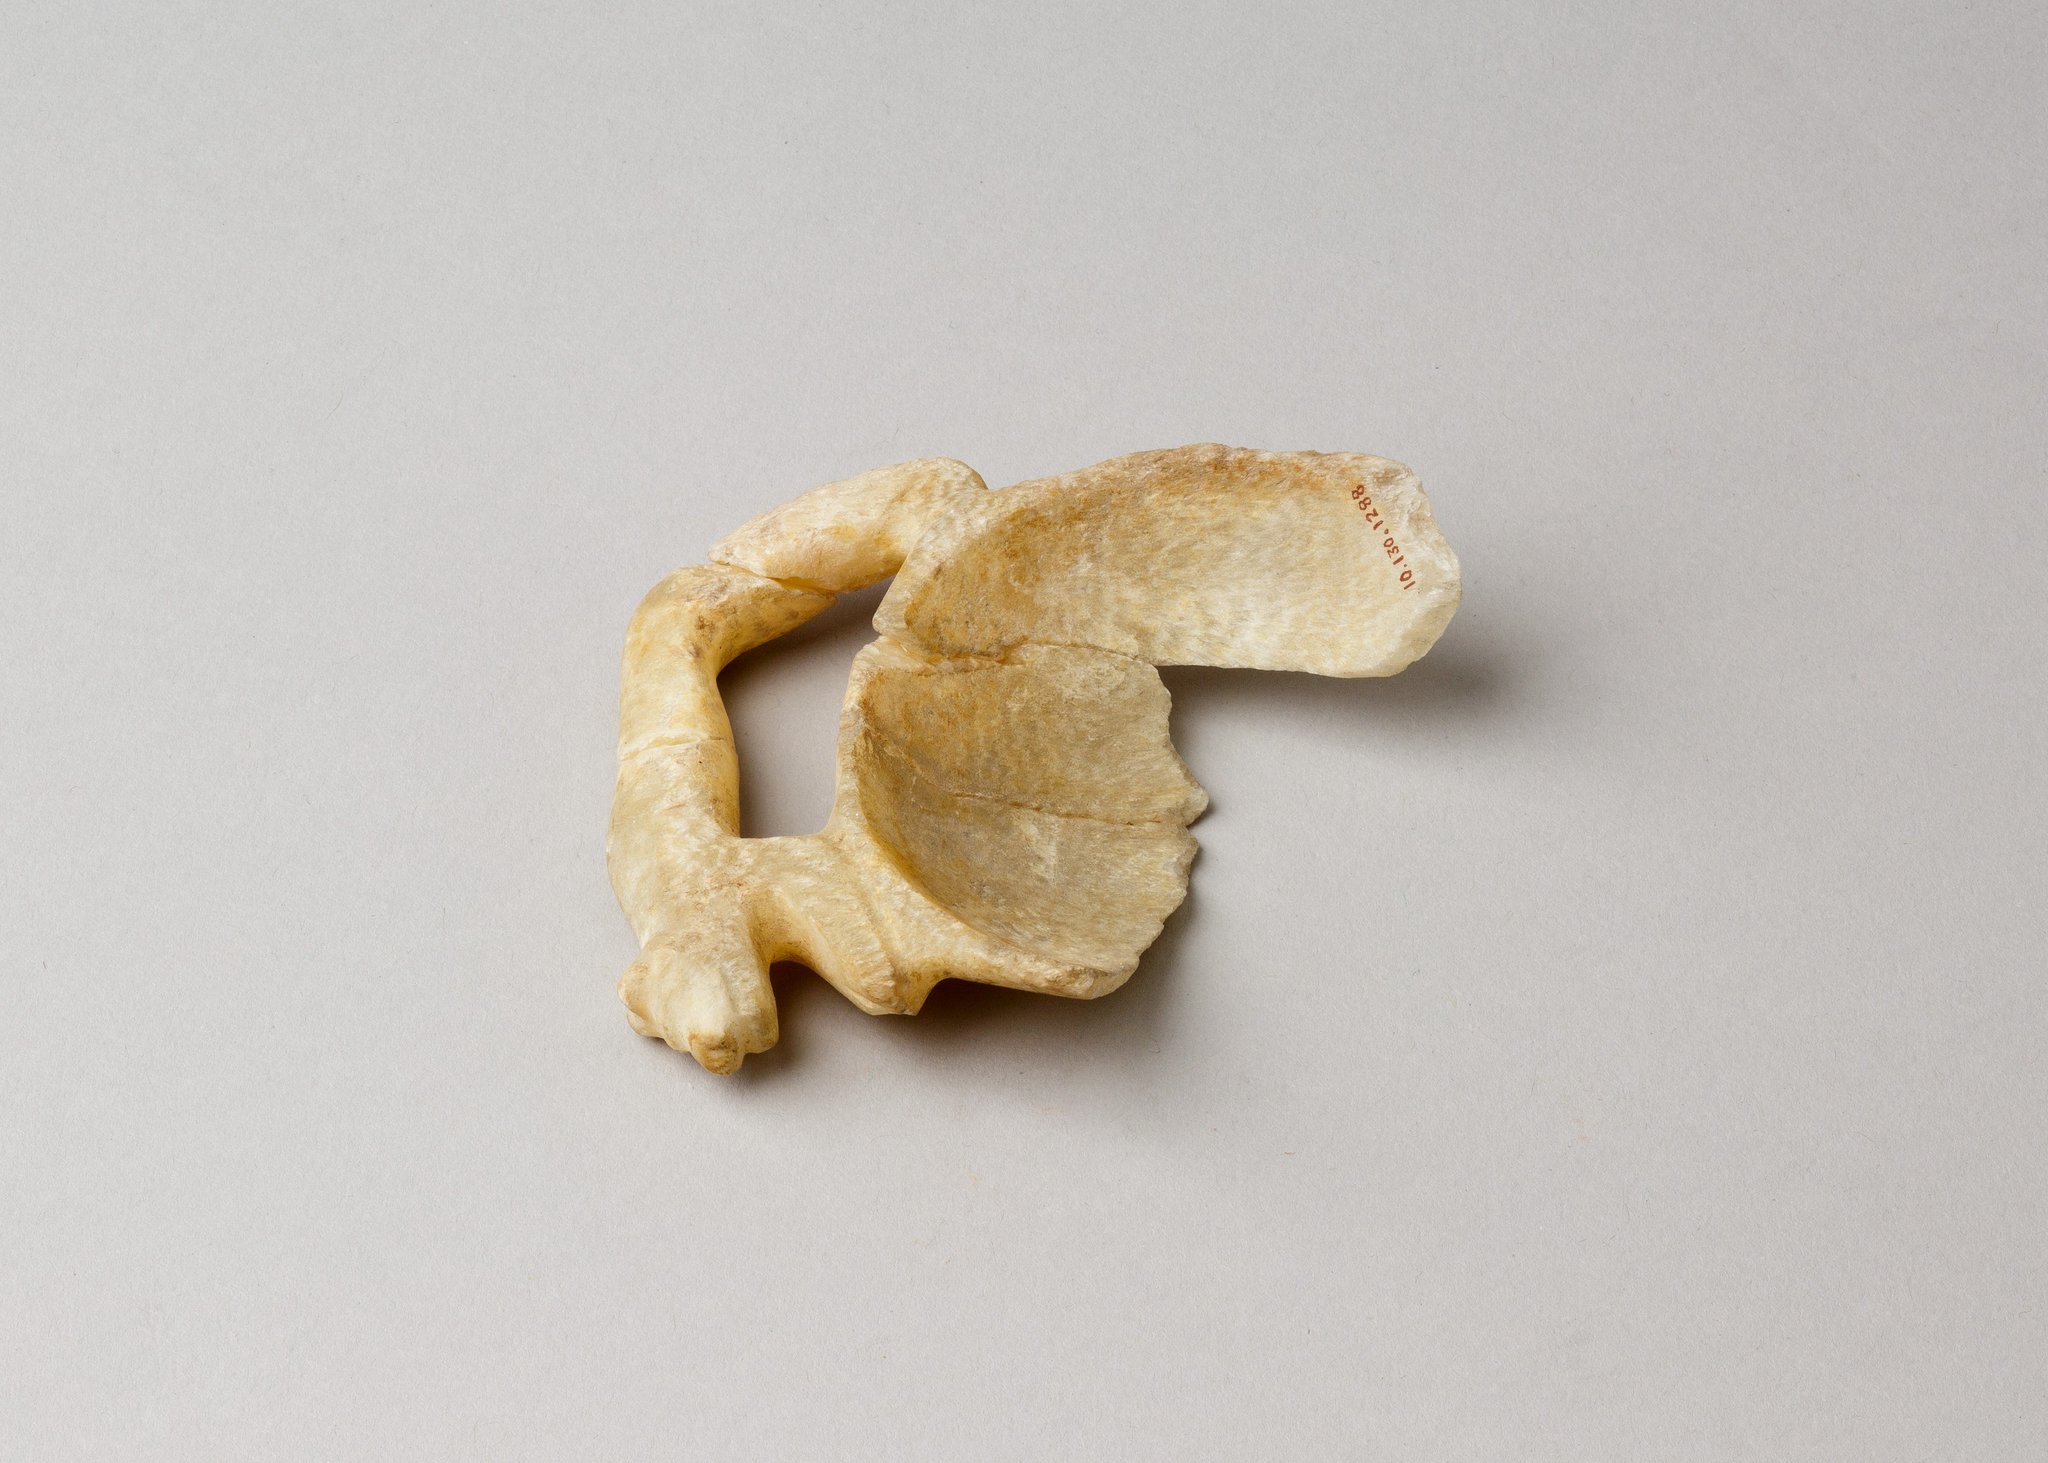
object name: cosmetic, spoon, feline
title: Cosmetic spoon with feline handle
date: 1550-1295 BCE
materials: stone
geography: egypt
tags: animals